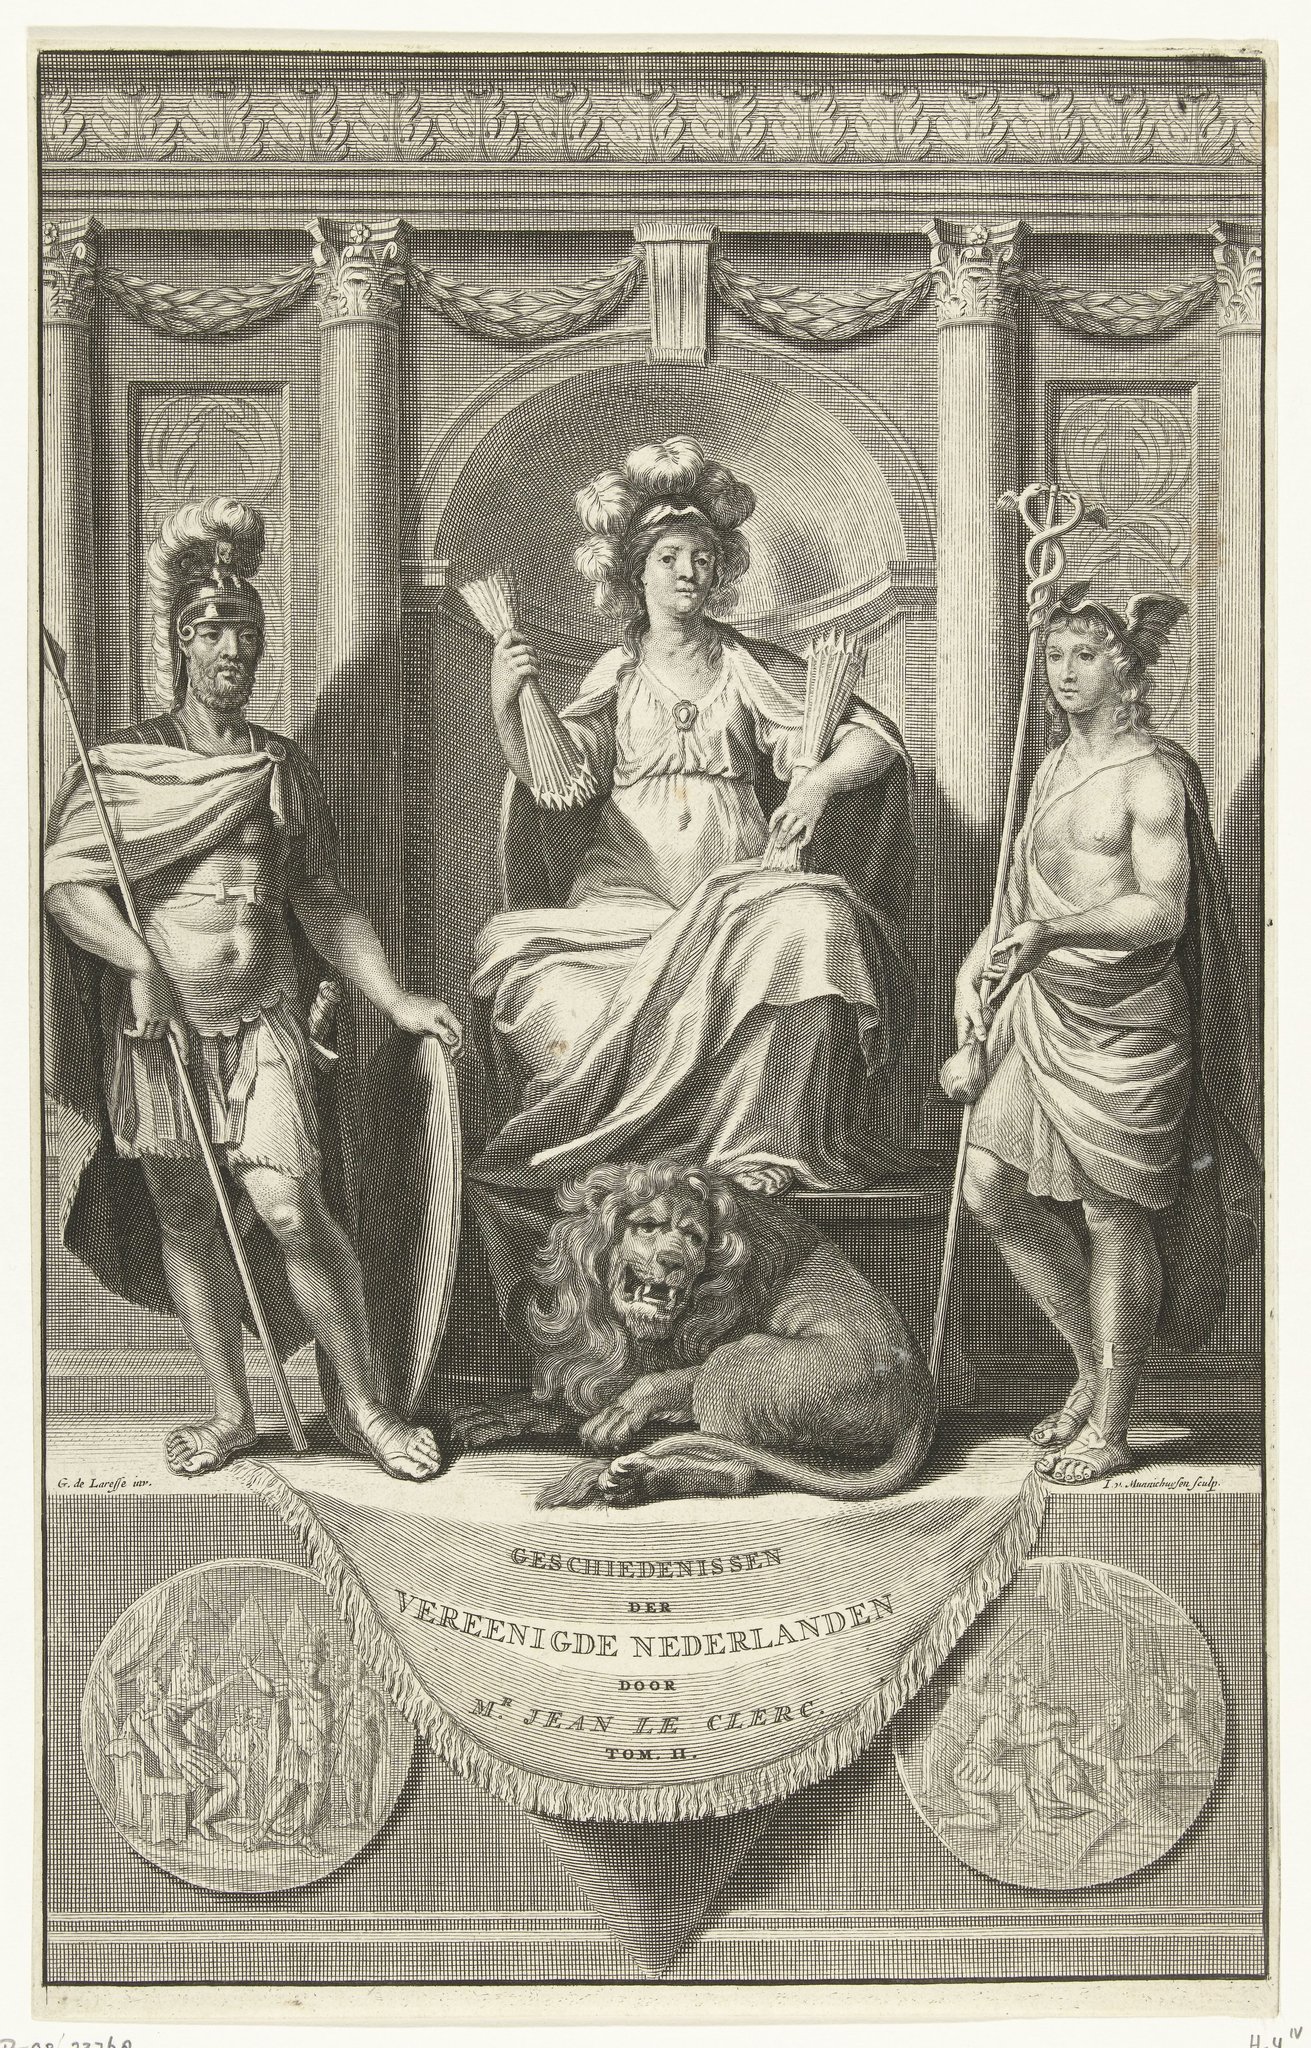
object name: titelblad, titelpagina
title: Hollandse maagd geflankeerd door Mars en Mercurius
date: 1677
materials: paper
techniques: engraving, etching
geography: amsterdam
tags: (story of) mars (ares), personifications of countries, nations, states, districts, etc., (story of) mercury (hermes), netherlands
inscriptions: collector's mark: Lugt 2228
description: Titelpagina voor: Le Clerc, Jean. Geschiedenissen der Vereenigde Nederlanden. 3 dln. Amsterdam: Zacharias Chatelain (II), 1730. Eerdere staat van deze prent gebruikt als titelpagina voor: Hooft, Pieter Corneliszoon. Nederlandsche historien. Amsterdam: Joannes van Someren, Abraham Wolfgang, Dirk Boom (I), Hendrick Boom, Jacob de Jonge, 1677.